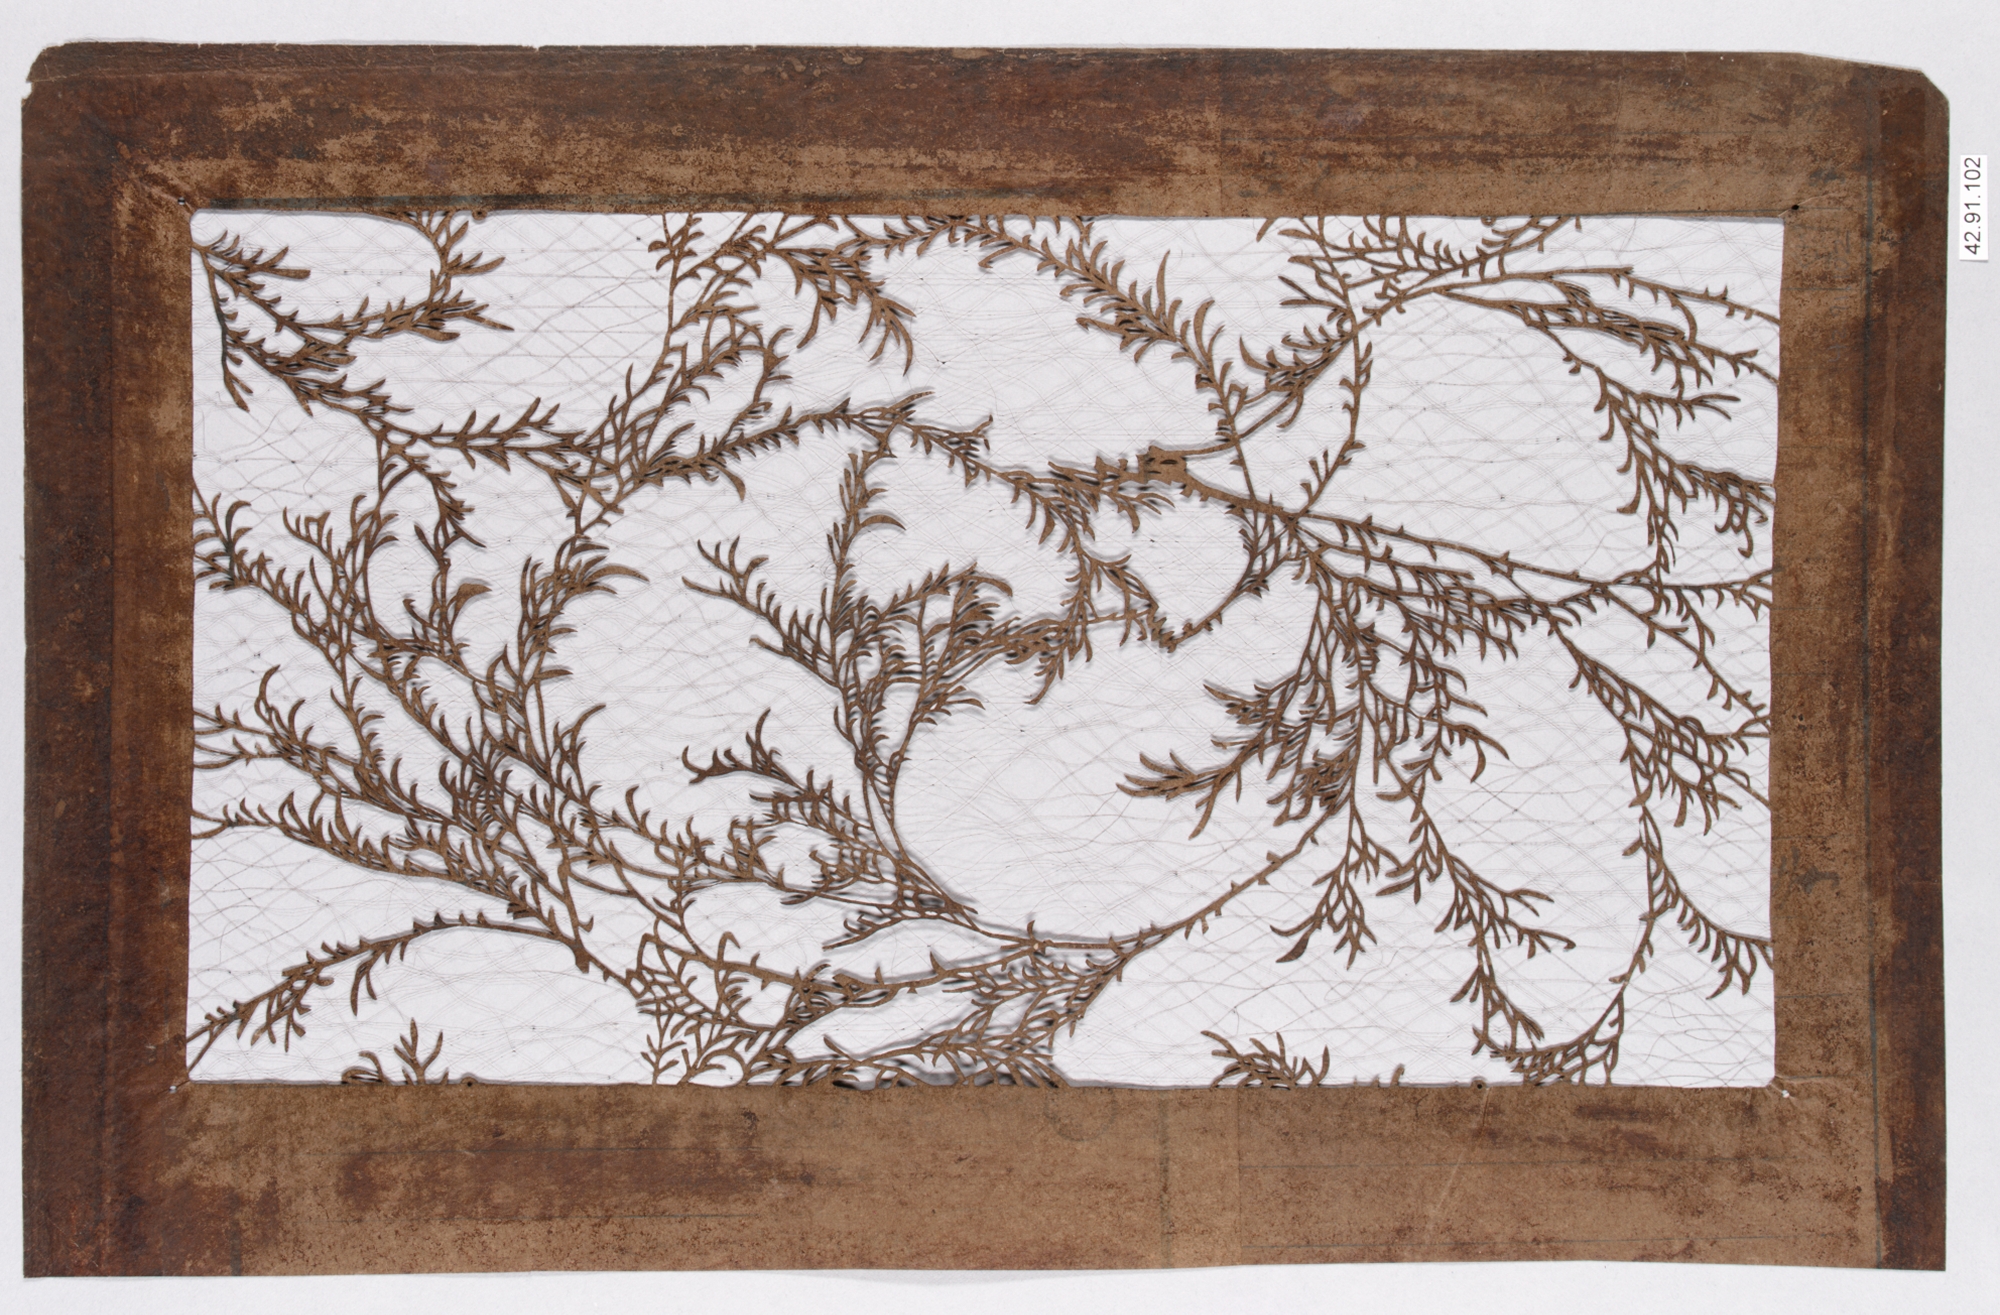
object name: stencil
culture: japanese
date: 1801-1900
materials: paper, silk